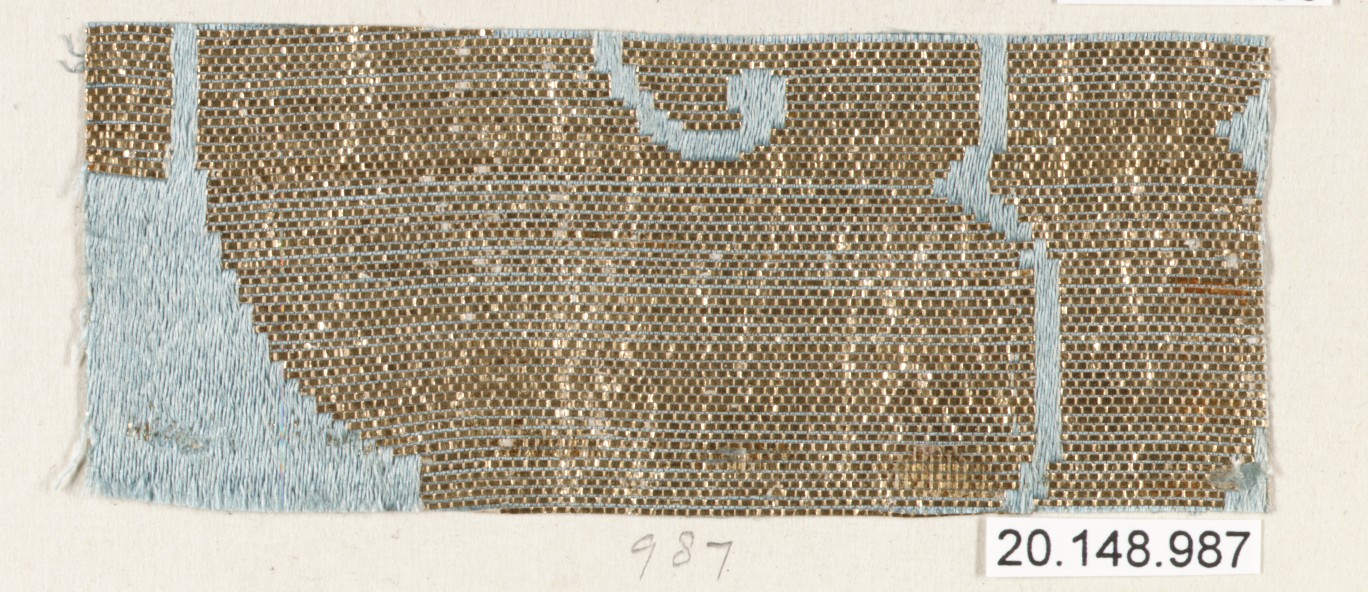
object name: piece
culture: japanese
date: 1701-1800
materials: silk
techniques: compound weave